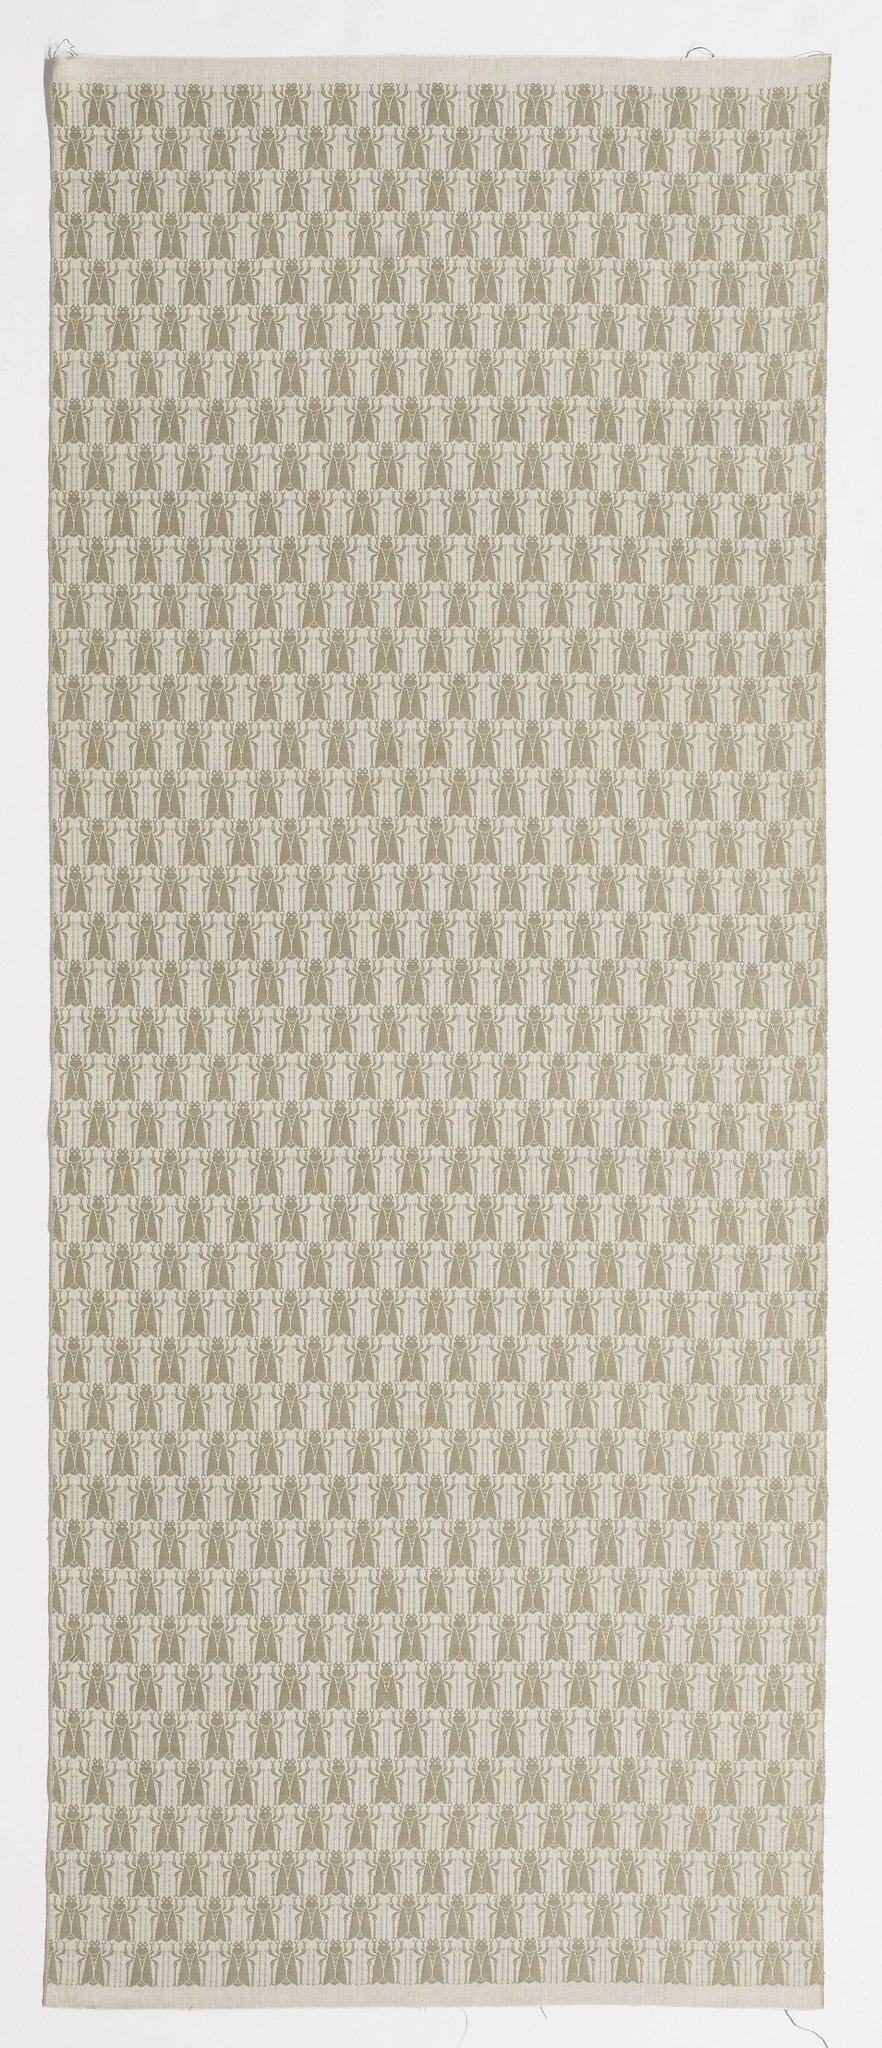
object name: upholstered wall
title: Wandbespanning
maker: chris lebeau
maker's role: draughtsman, print maker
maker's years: 1878-1945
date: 1911-1915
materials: linen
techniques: damask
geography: eindhoven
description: Groenig grijze damasten wandbespanning met een dessin van bijen.